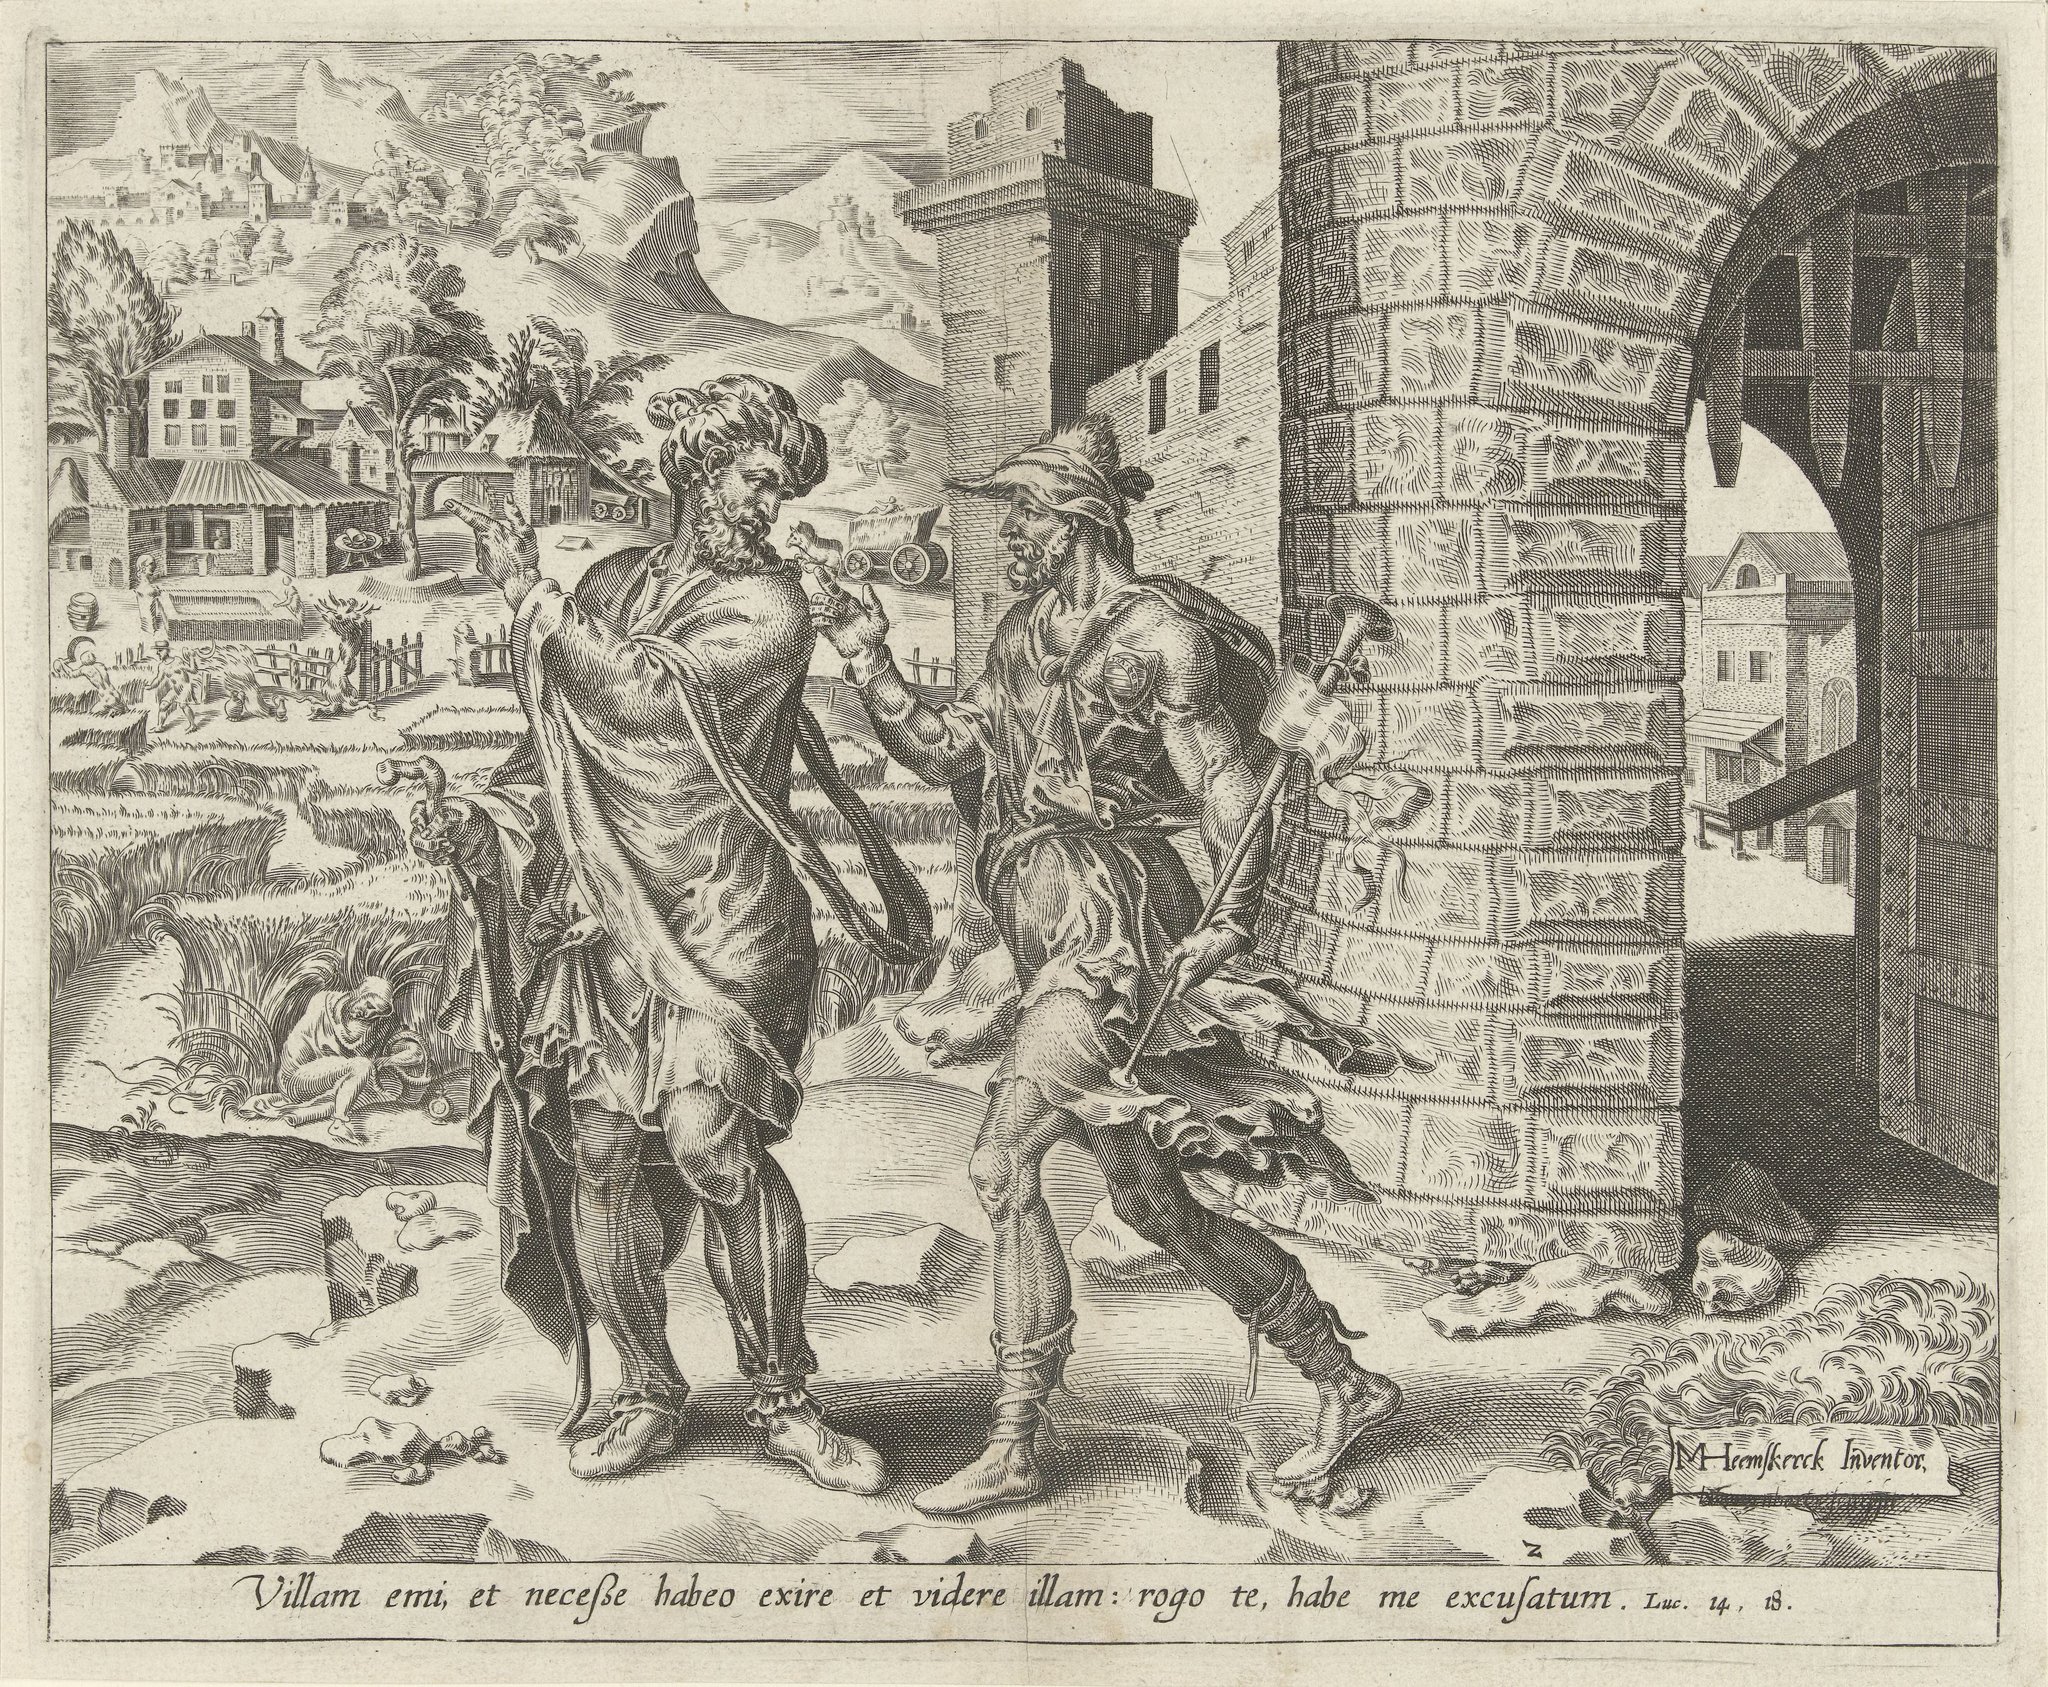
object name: print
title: Gelijkenis van een bruiloftsfeest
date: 1558-1559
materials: paper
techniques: engraving, etching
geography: haarlem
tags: those that are invited to the royal wedding-feast excuse themselves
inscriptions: collector's mark: Lugt 2228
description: De boodschapper komt bij de eerste gast en nodigt hem uit voor het feest. De gast verontschuldigt zich met het voorwendsel dat hij een nieuwe akker heeft gekocht. Hij wijst naar de akker op de achtergrond. De prent heeft een Latijns onderschrift en maakt deel uit van een zesdelige serie over de gelijkenis van een bruiloftsfeest.